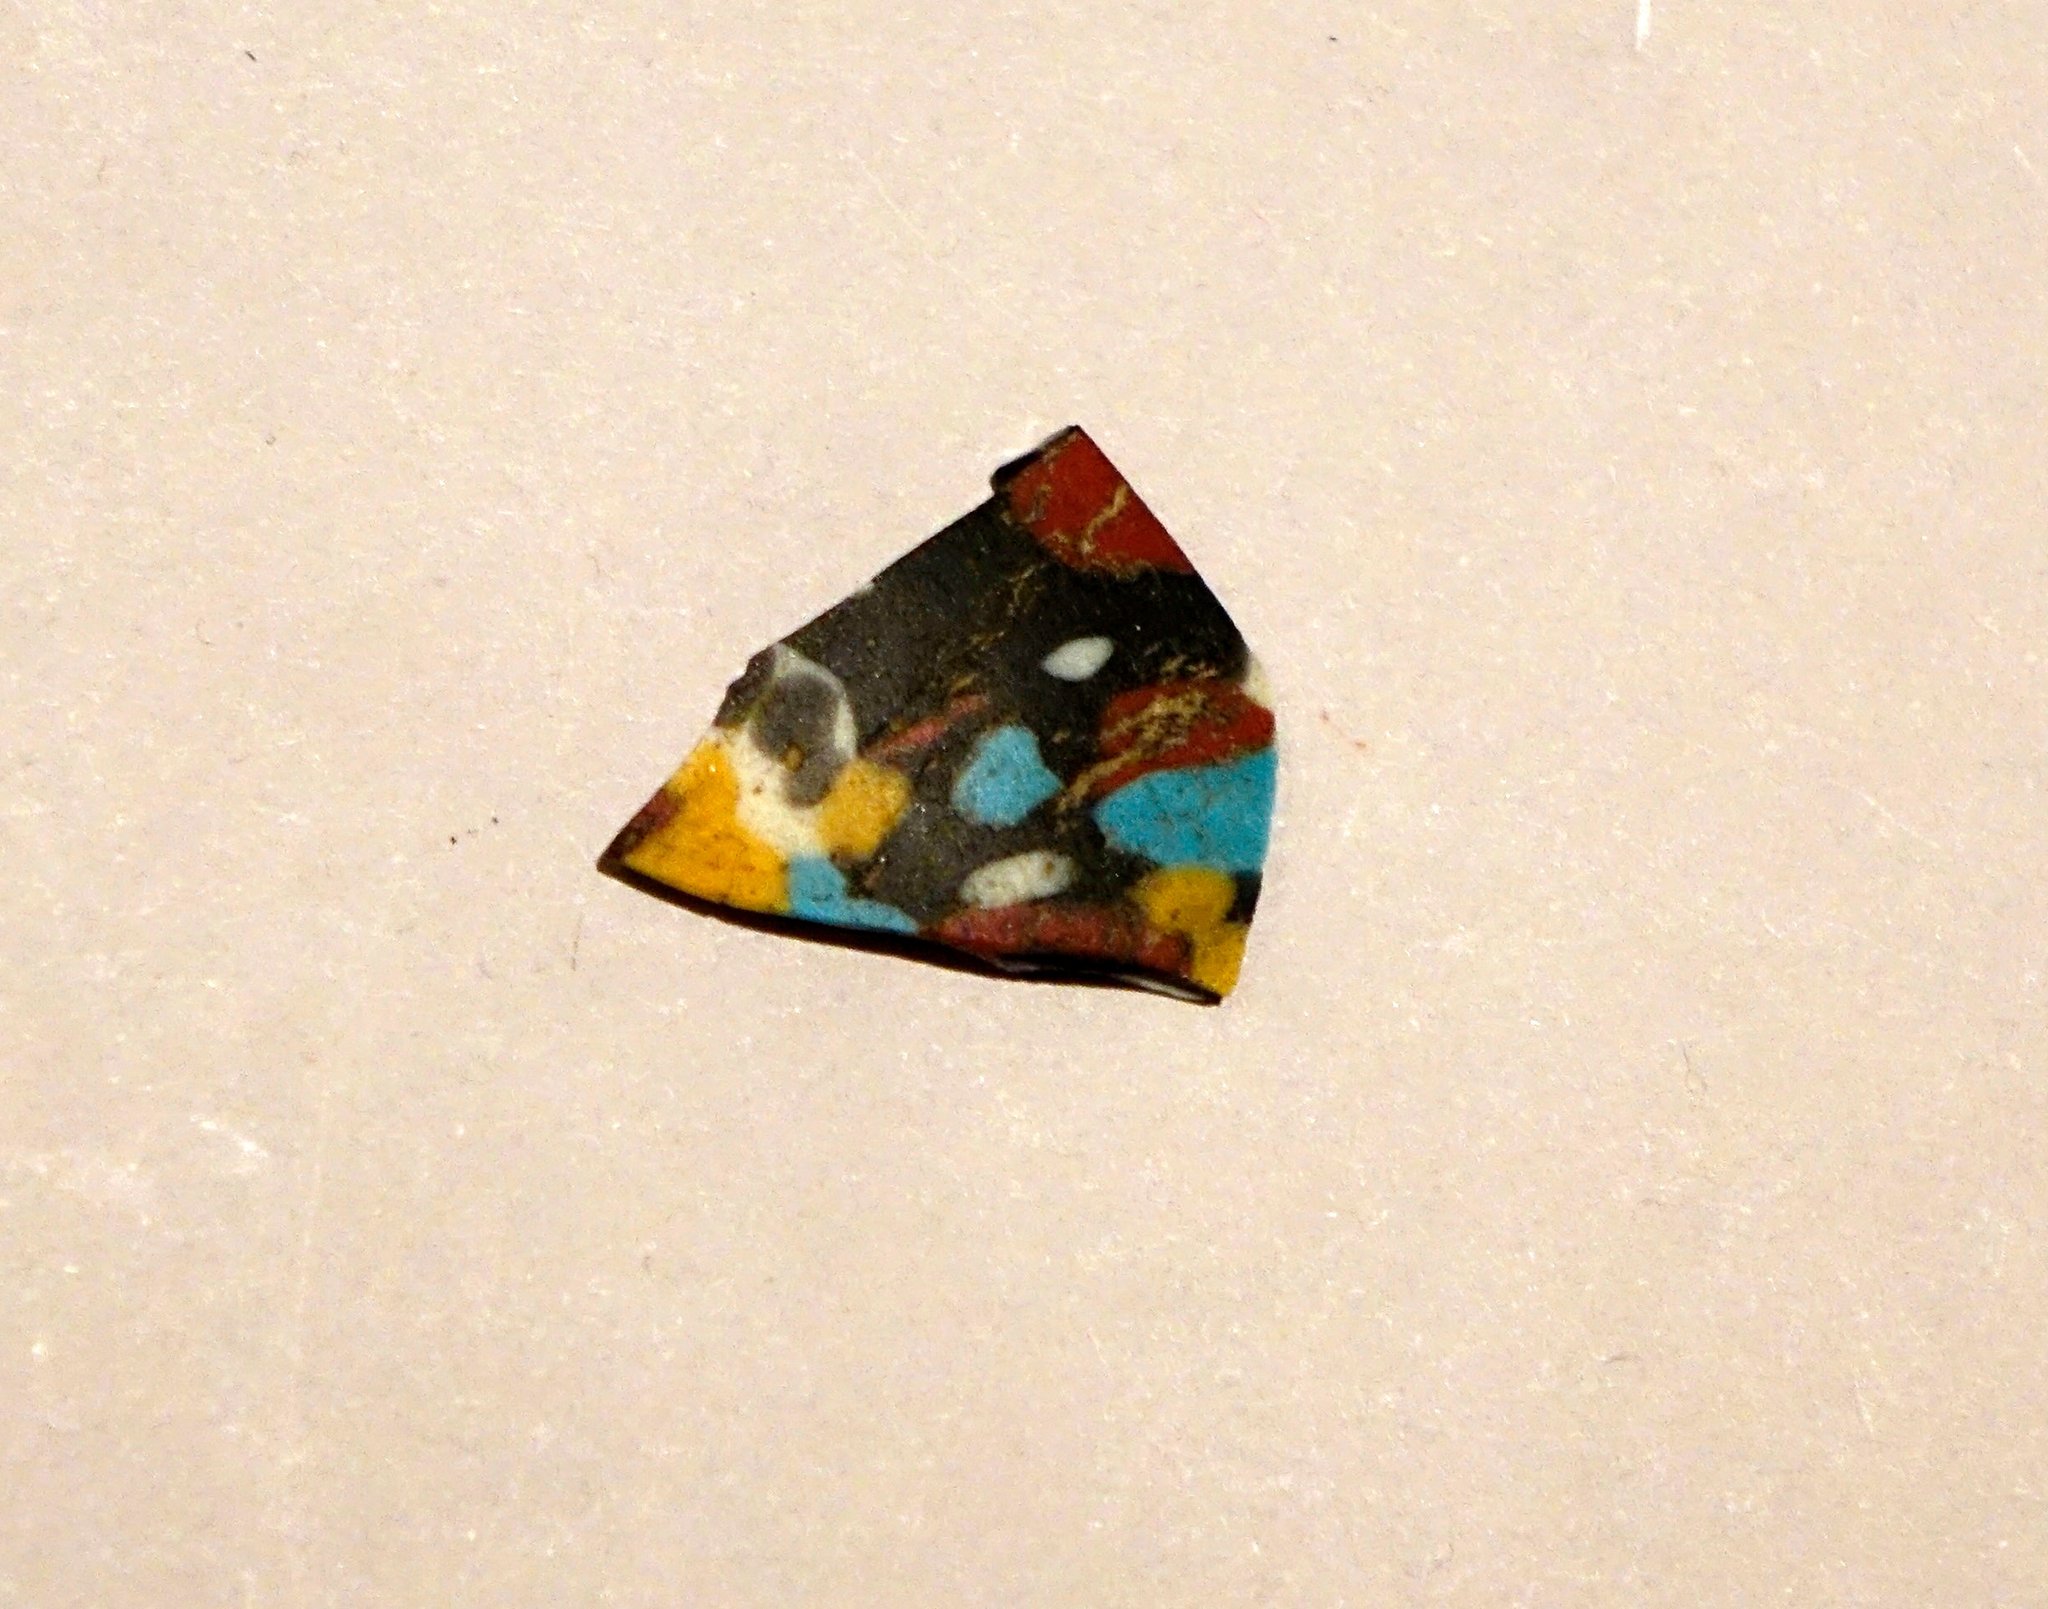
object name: vessel fragment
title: Glass Vessel Fragment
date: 1390-1353 BCE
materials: glass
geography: upper egypt, thebes